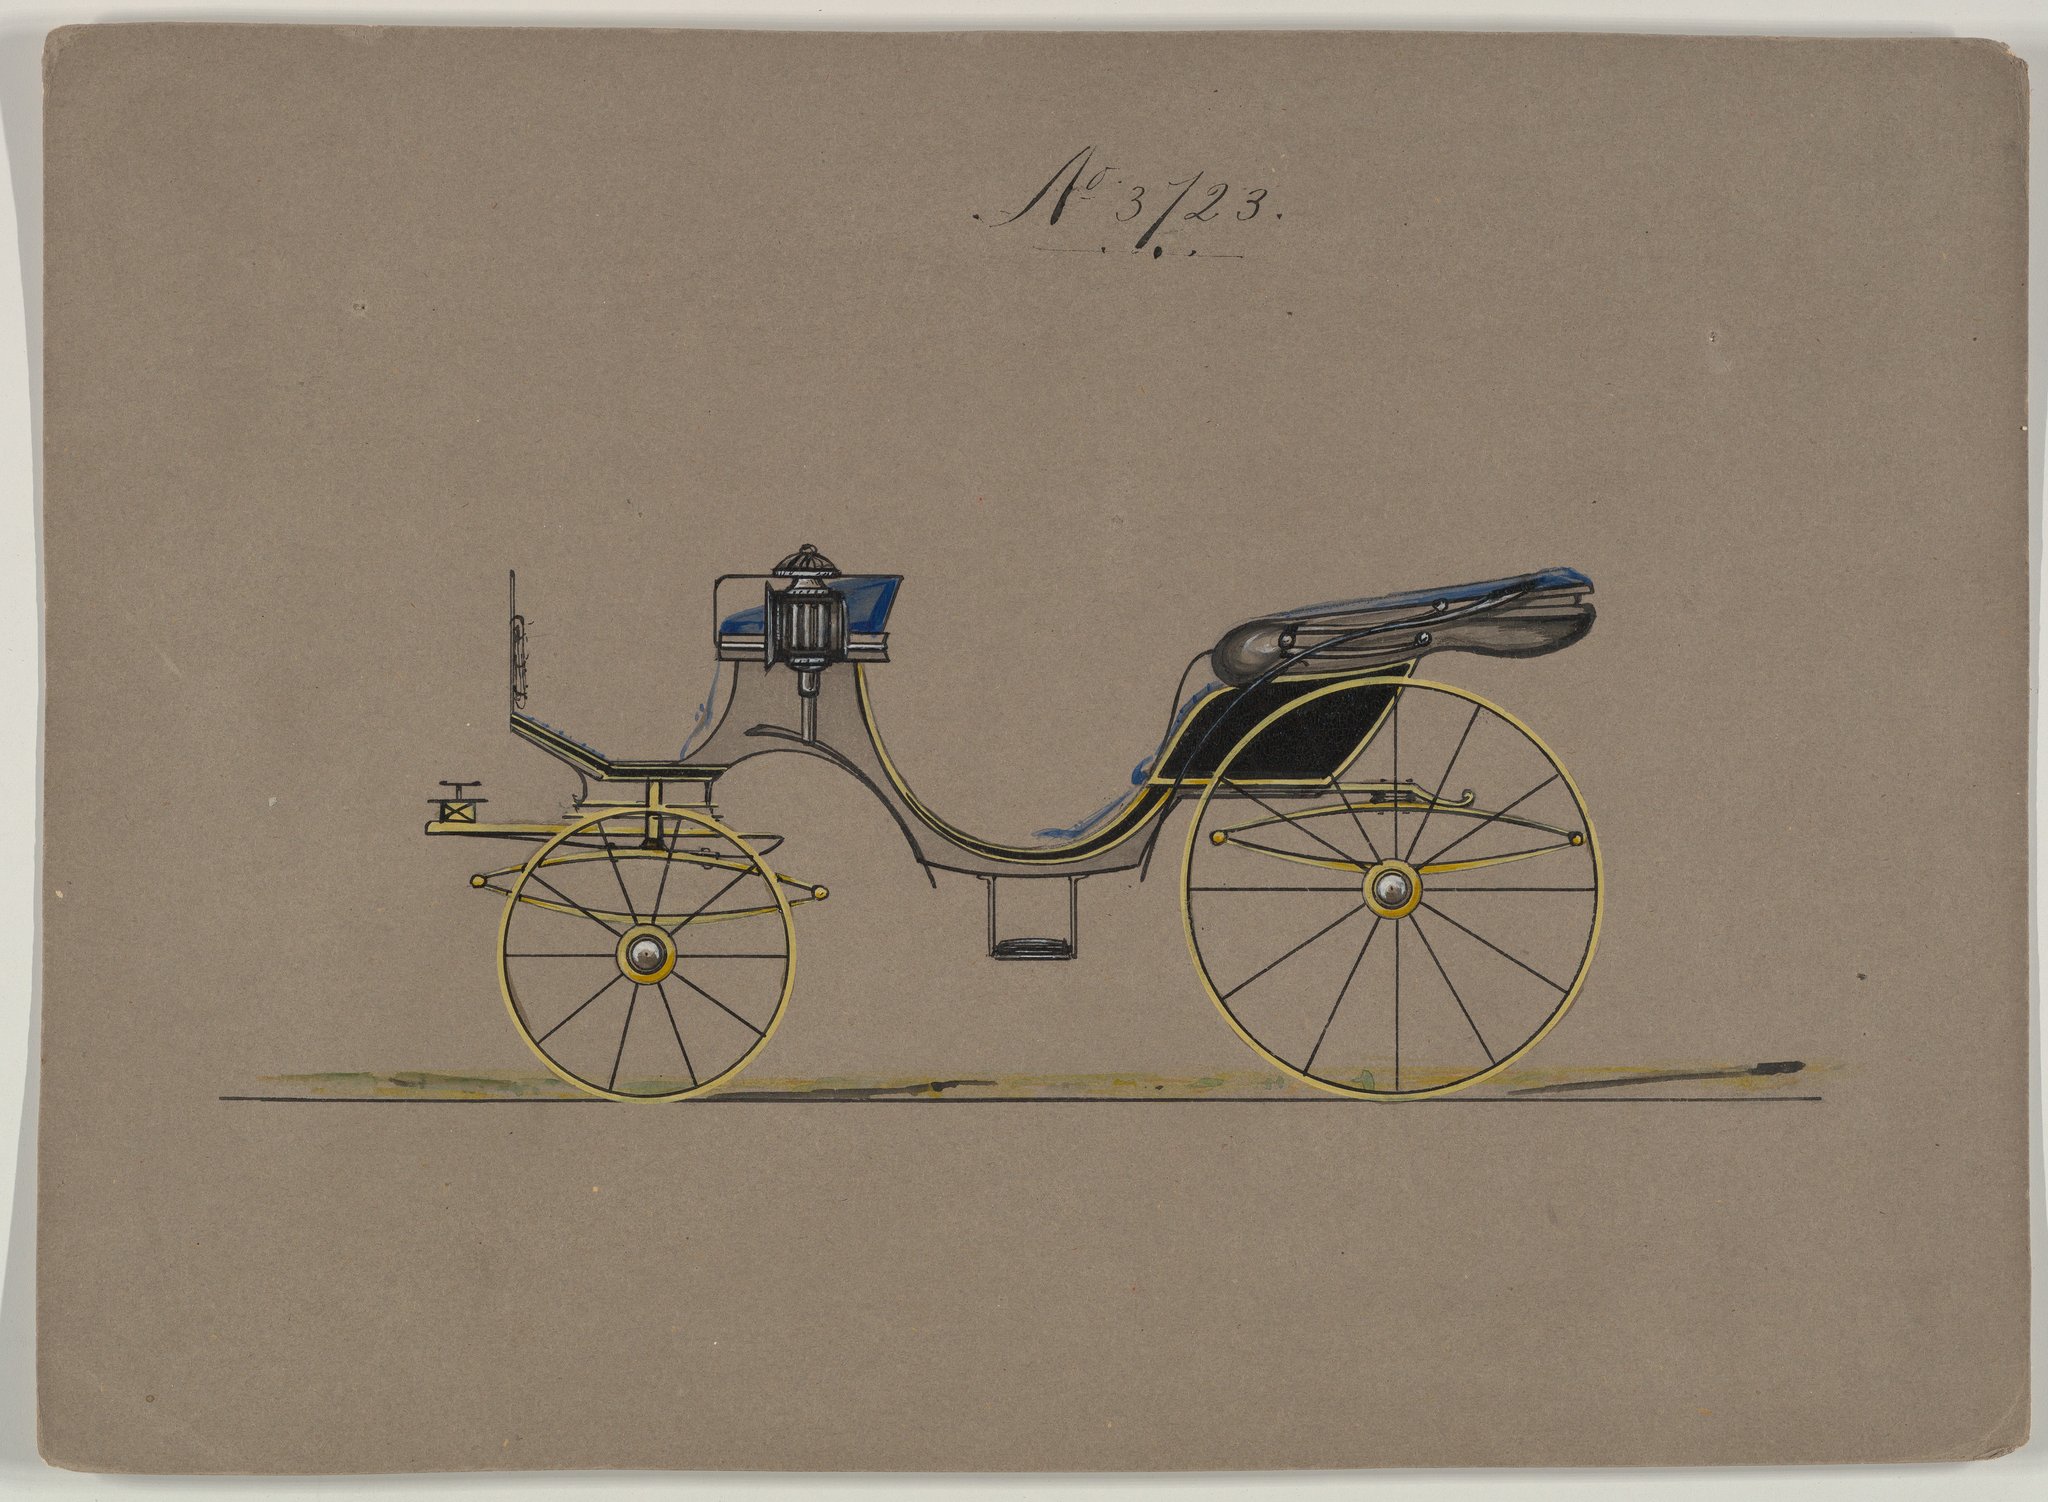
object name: drawing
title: Design for Cabriolet or Victoria, no. 3723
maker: brewster & co.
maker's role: manufacturer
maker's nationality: american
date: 1881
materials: gouache, gum arabic, ink, watercolor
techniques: pen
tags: carriages